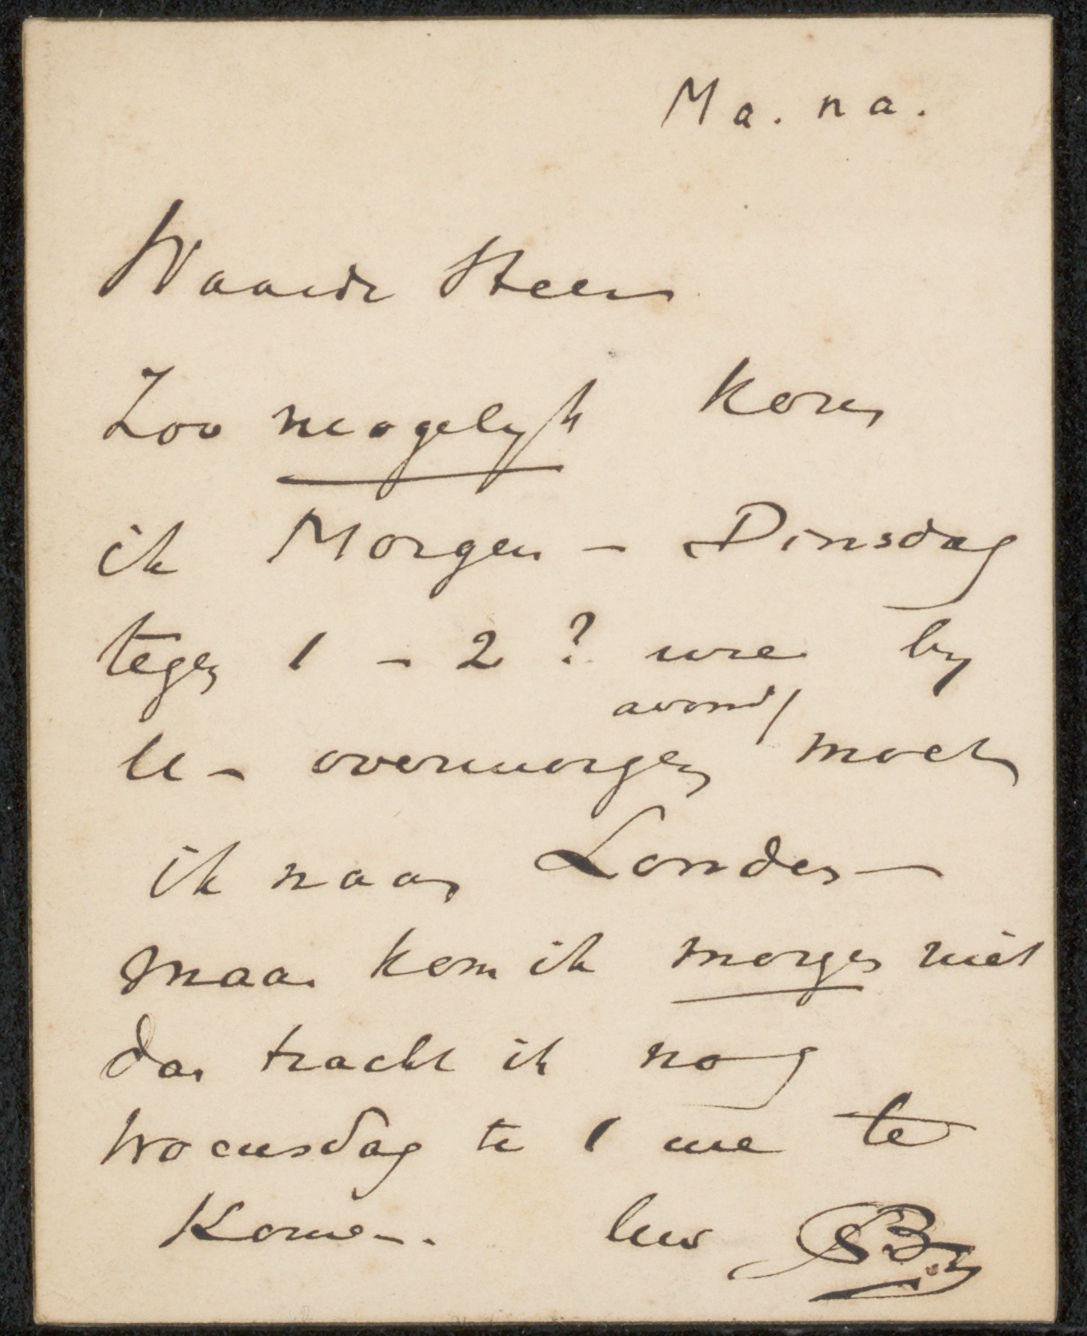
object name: letter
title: Brief aan Philip Zilcken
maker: abraham bredius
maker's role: kunsthistoricus, museumdirecteur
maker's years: 1855-1946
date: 1865-1946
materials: cardboard, ink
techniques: pen, writing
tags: the hague, painter, philip zilcken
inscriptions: collector's mark: ‘RPK’